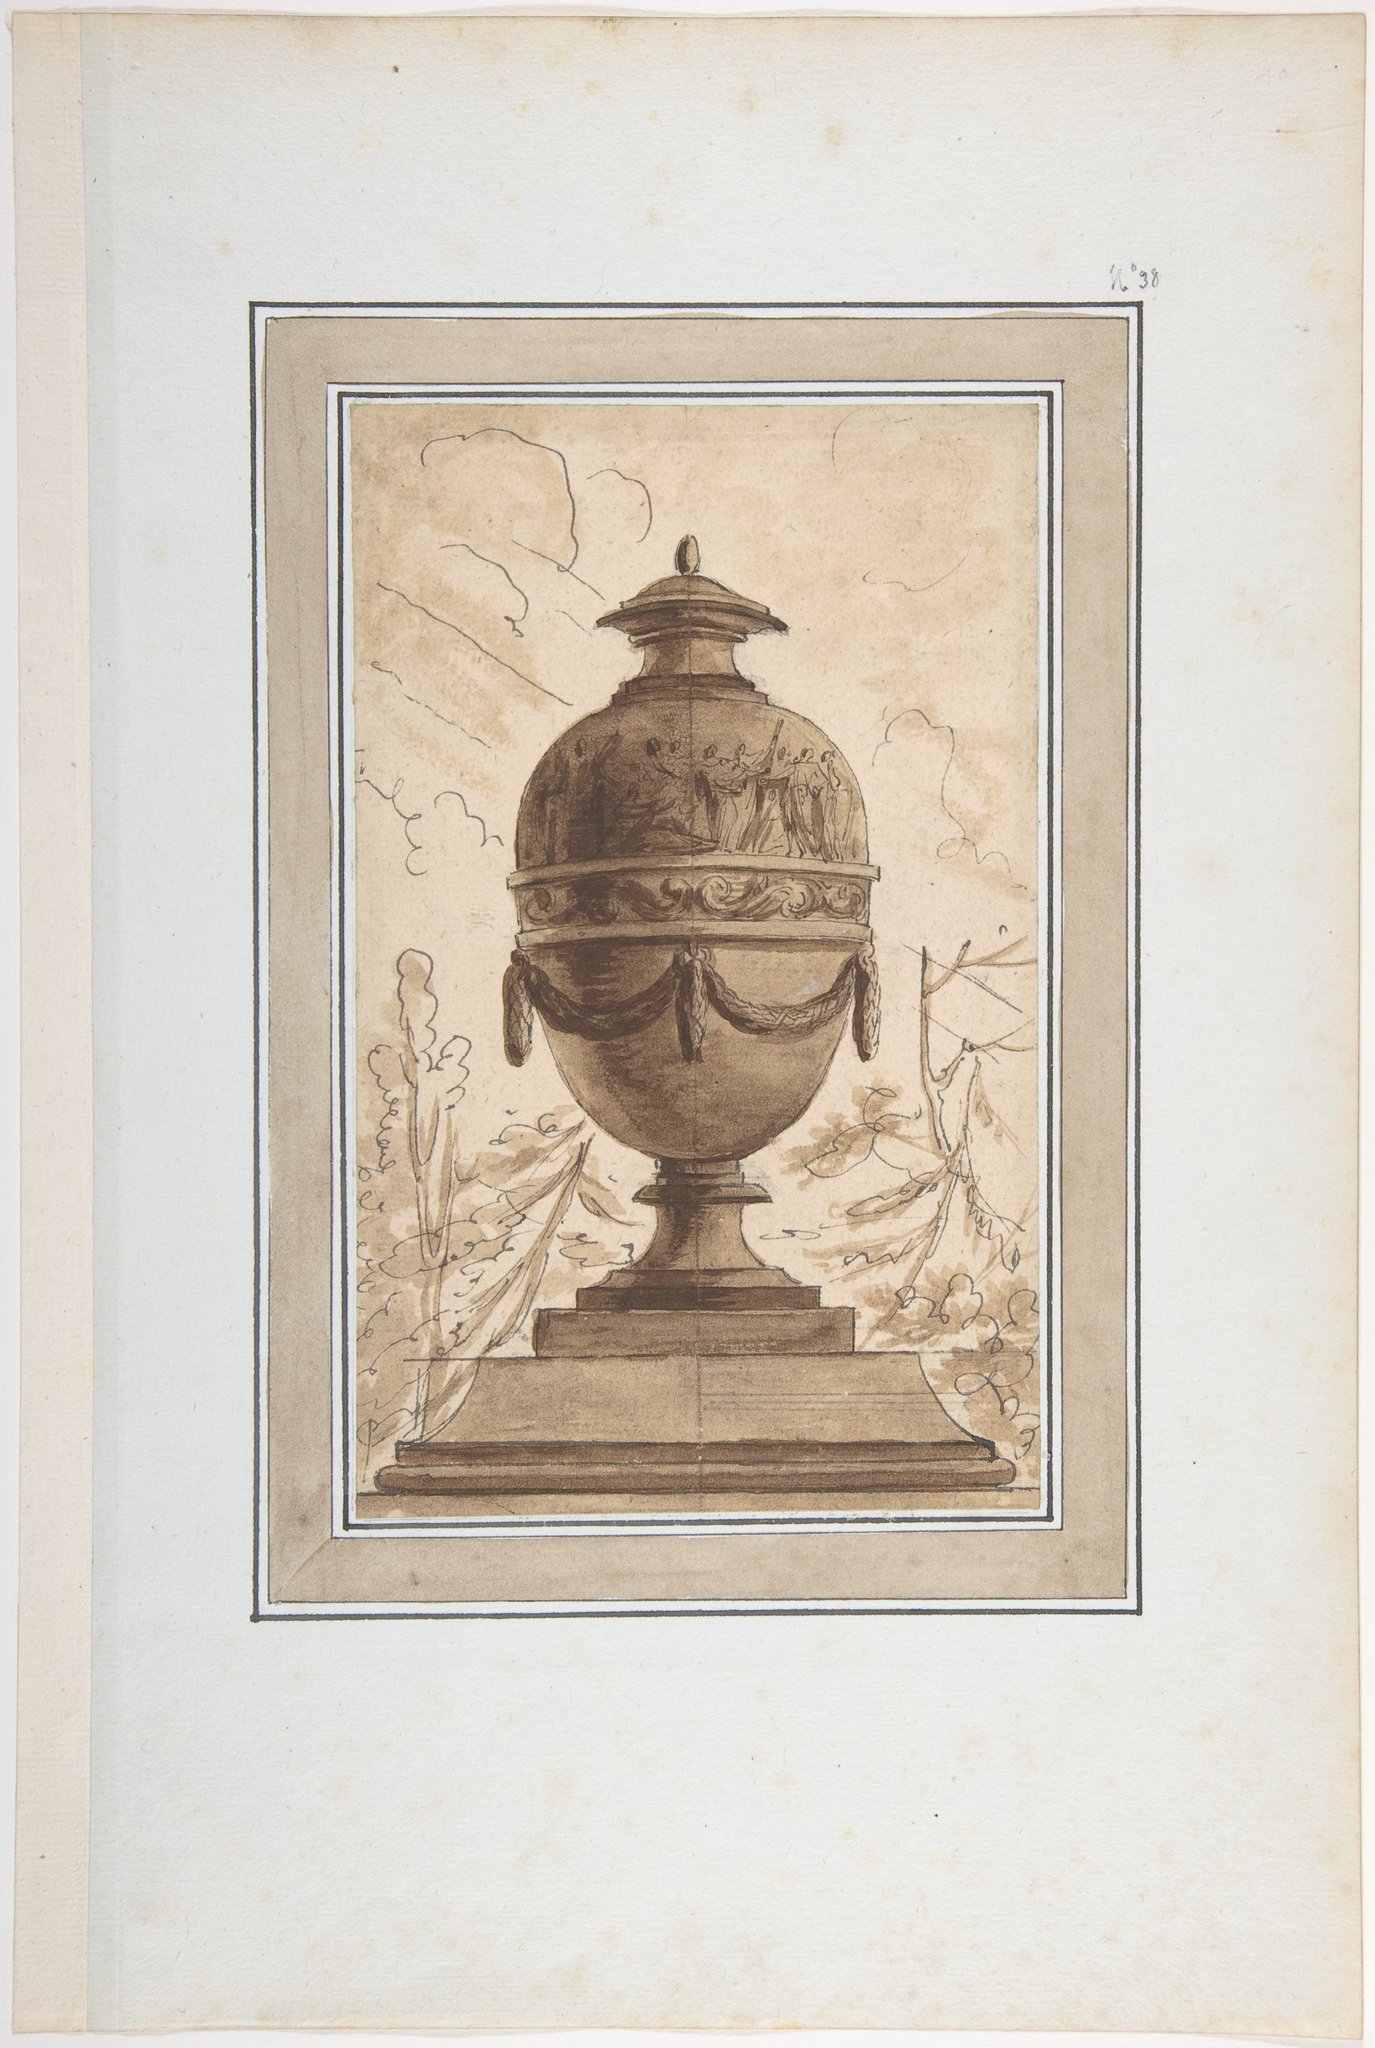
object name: drawing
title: Study for a Vase in a Suite of Vase Designs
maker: louis joseph le lorrain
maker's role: artist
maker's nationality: french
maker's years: 1715-1759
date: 1715-1759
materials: graphite, ink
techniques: brush, pen, drawing, wash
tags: vases